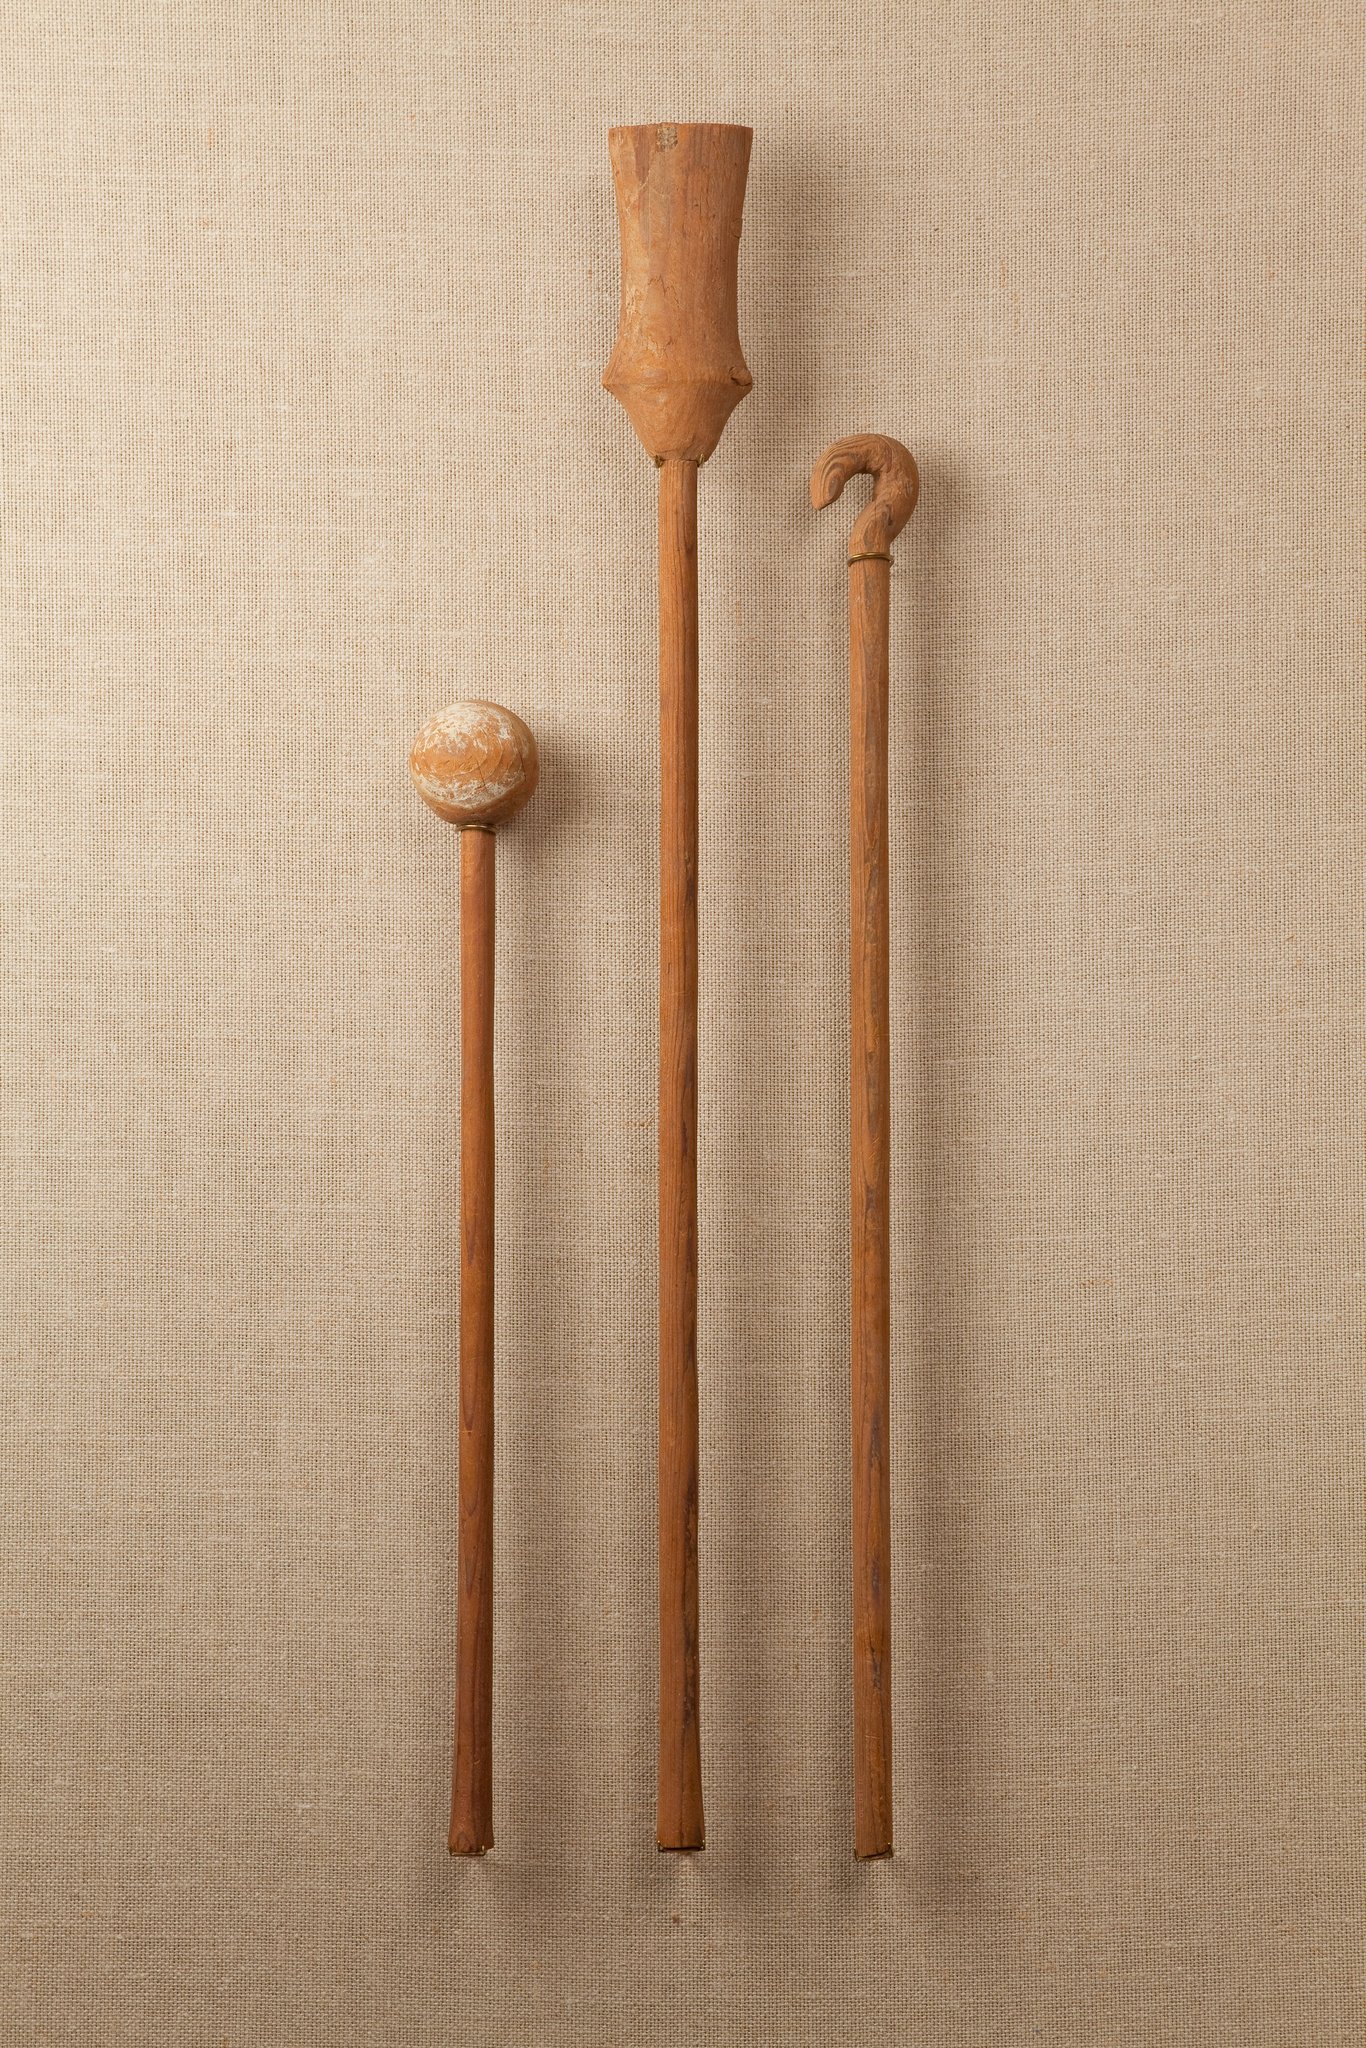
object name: model scepter, heka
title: Model heka scepter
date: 1981-1802 BCE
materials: wood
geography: egypt